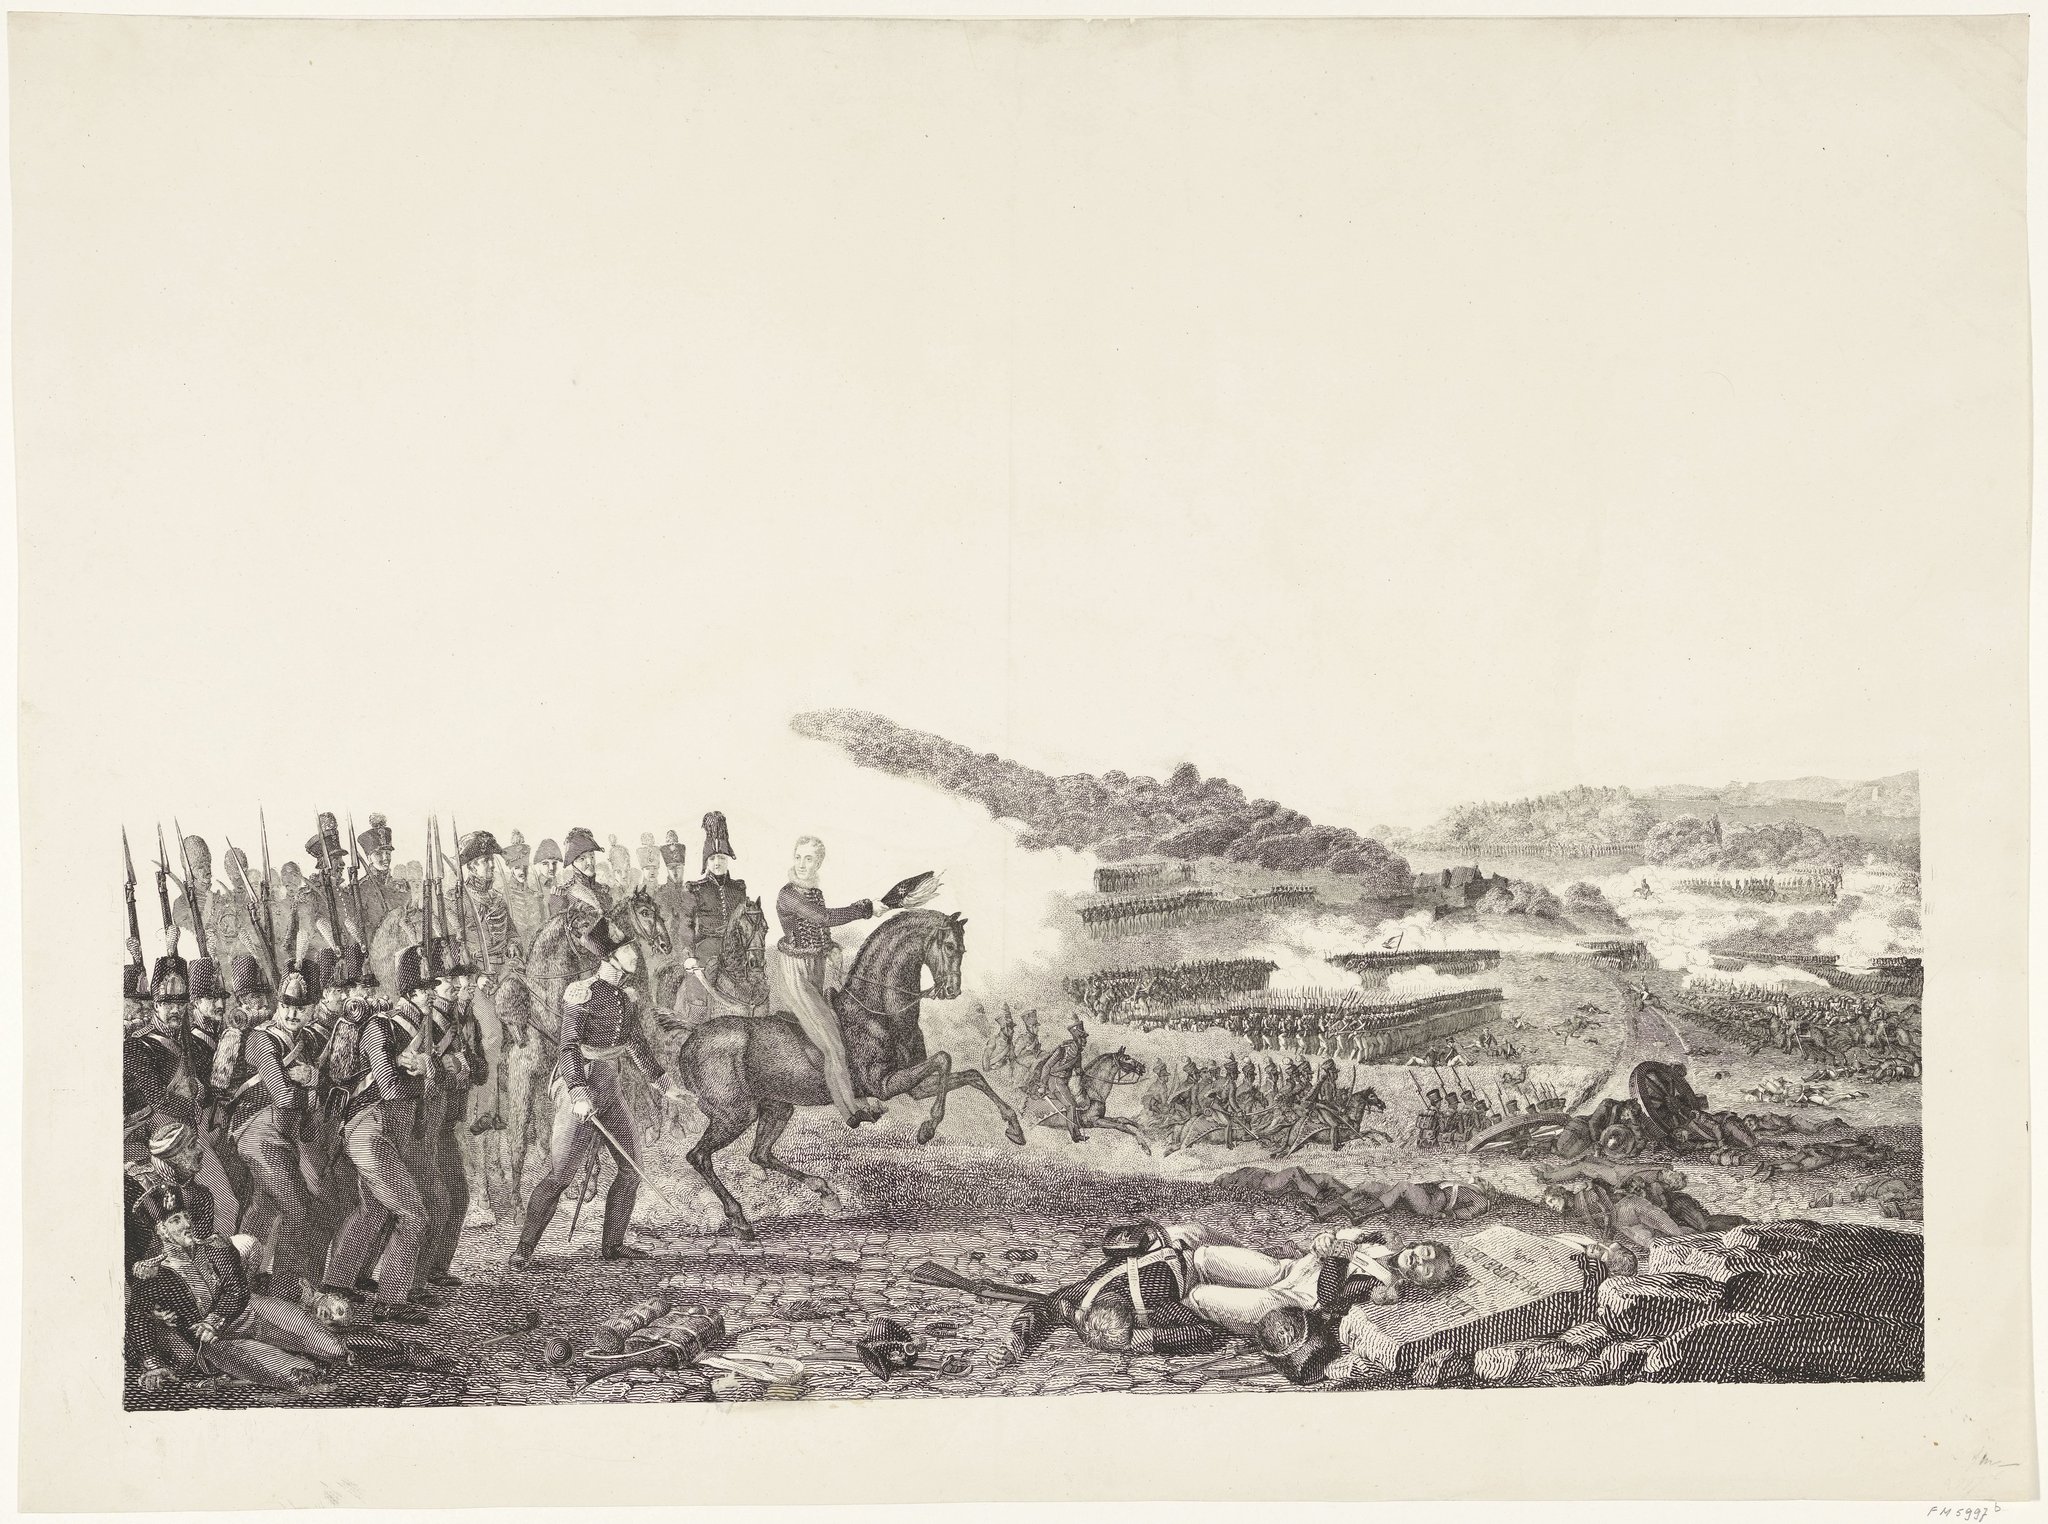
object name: print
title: Prins van Oranje leidt de Nederlandse troepen in de slag bij Quatre-Bras, 1815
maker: philippus velijn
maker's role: print maker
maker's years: 1787-1836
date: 1817-1818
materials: paper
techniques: etching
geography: netherlands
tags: william ii of the netherlands, battle (+ land forces)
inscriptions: collector's mark: Lugt 2228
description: De prins van Oranje te paard leidt de Nederlandse troepen in de slag bij Quatre-Bras, 16 juni 1815. Op de achtergrond felle gevechten, op de voorgrond gesneuvelde Franse soldaten bij de limietsteen van Quatre-Bras.